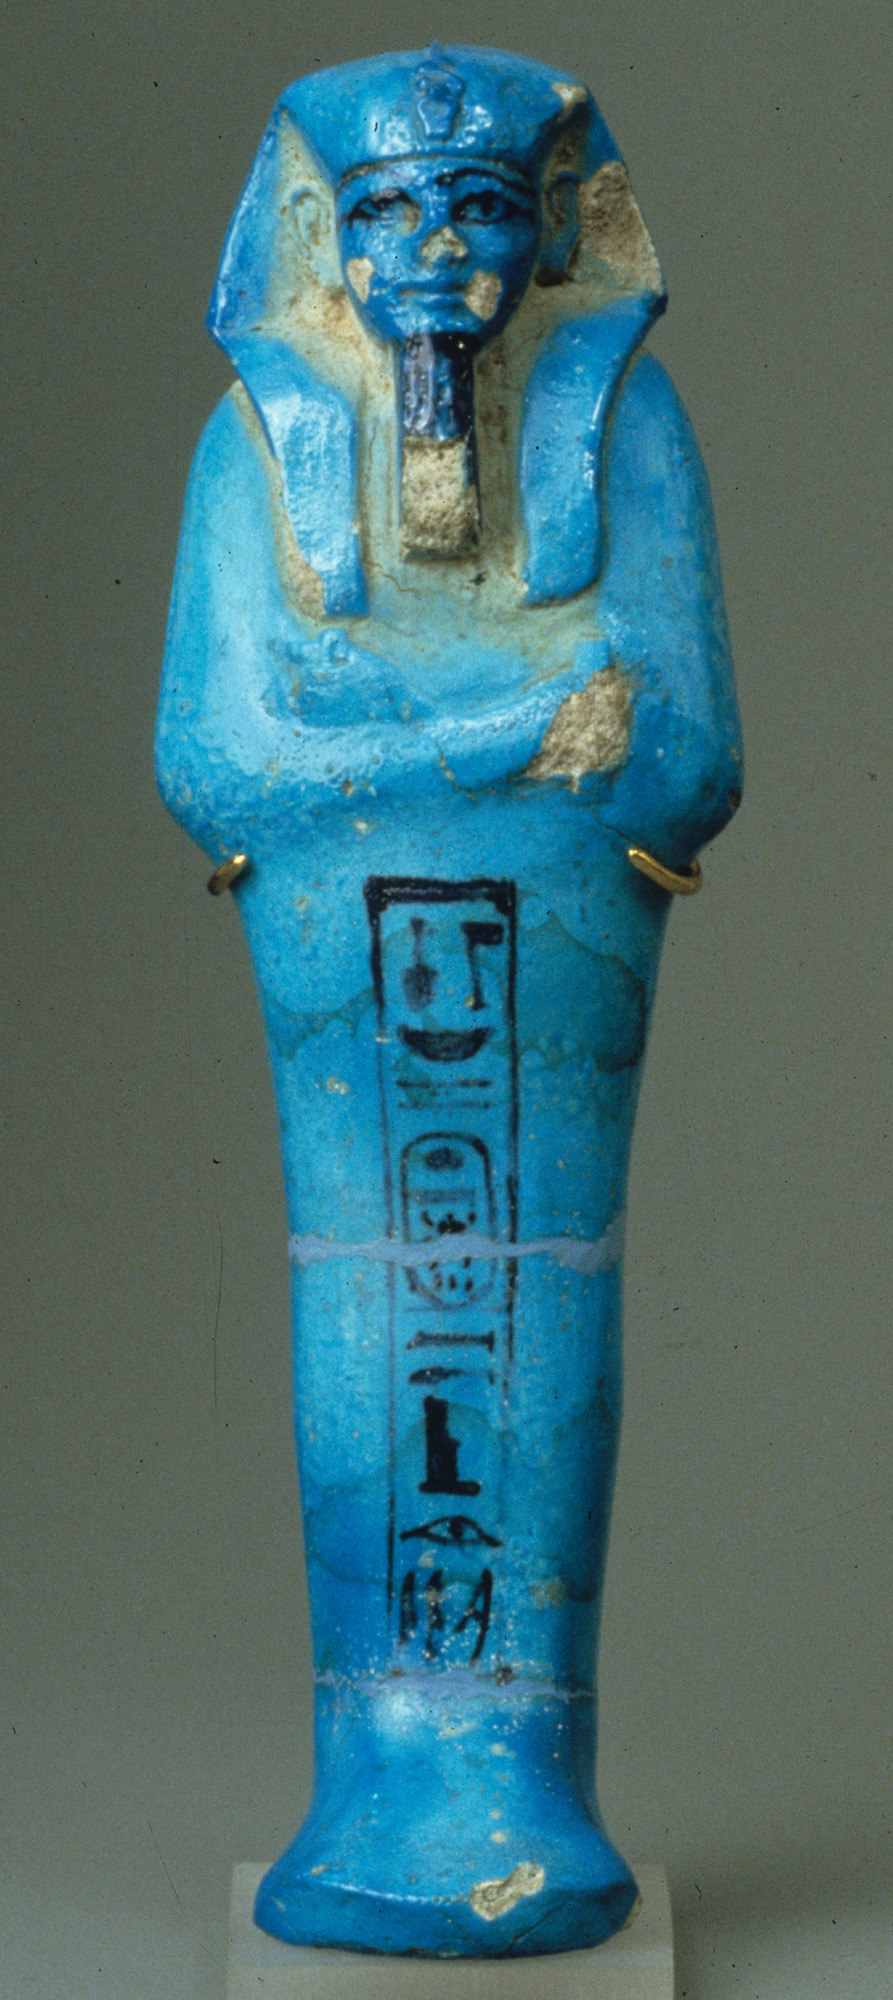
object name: shabti, thutmose iv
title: Shabti of Thutmose IV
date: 1400-1390 BCE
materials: faience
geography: egypt